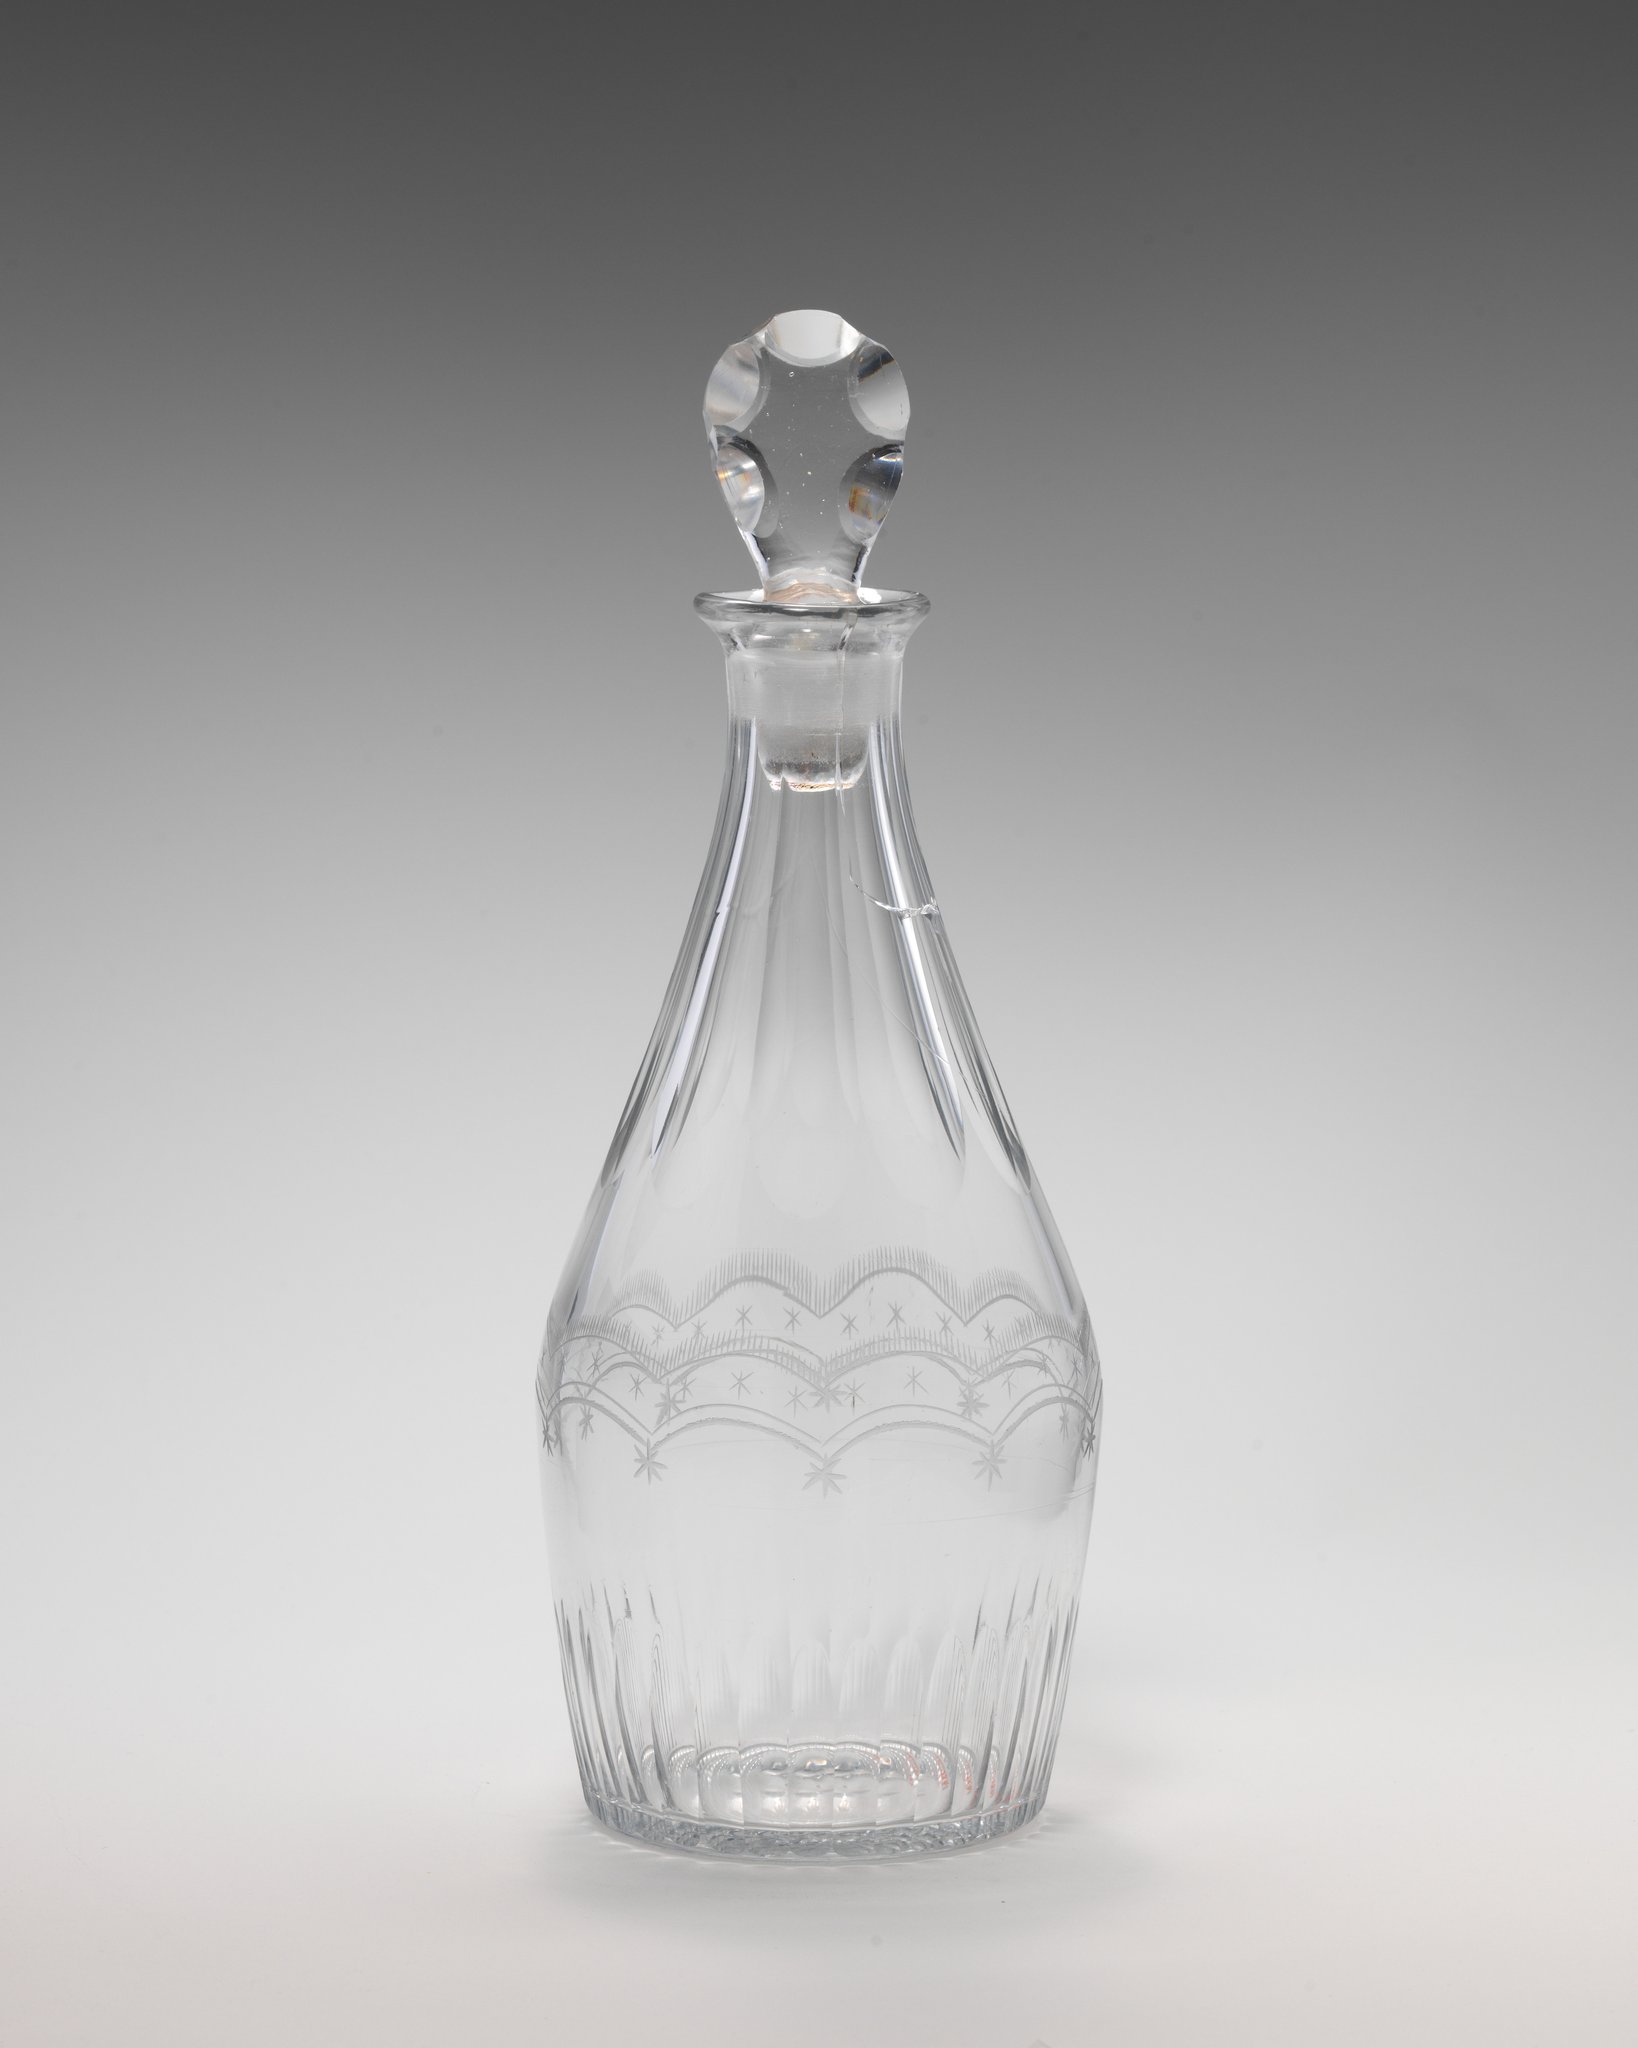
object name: decanter with stopper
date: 1701-1800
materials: glass